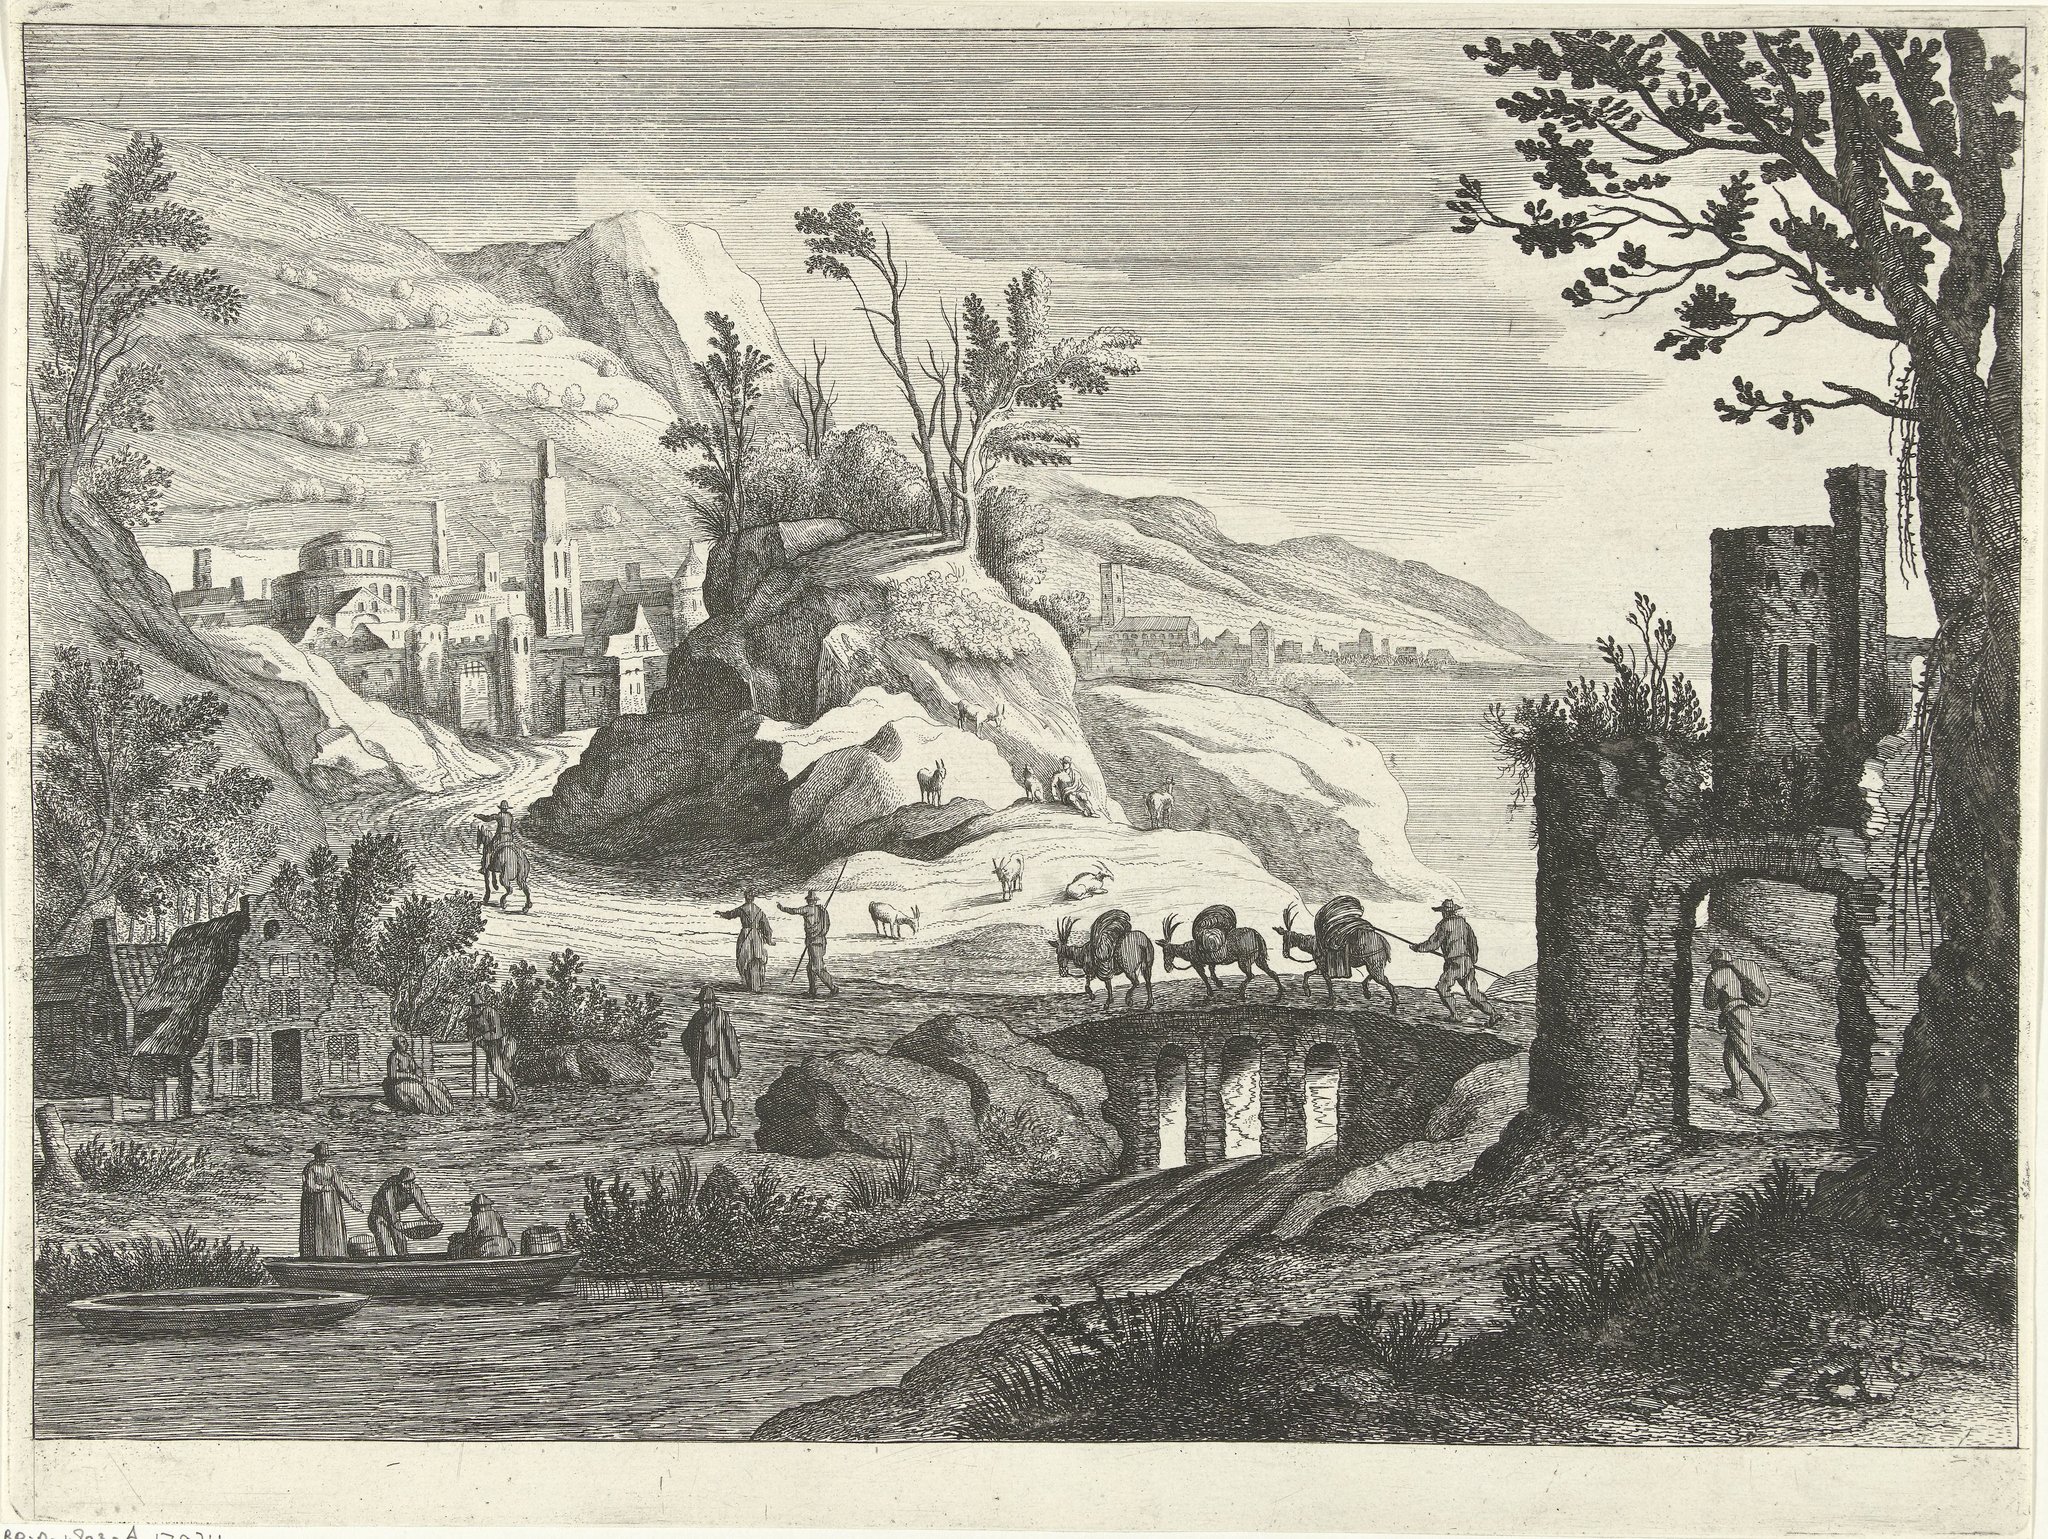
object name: print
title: Italiaans landschap met gezicht op een stad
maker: willem van de lande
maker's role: print maker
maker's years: 1610-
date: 1635-1650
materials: paper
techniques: etching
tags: ass, donkey, outskirts of city - ii - ideal city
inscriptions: collector's mark: Lugt 2228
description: Italiaans landschap met links een gezicht op een stad. Op de voorgrond worden drie bepakte ezels over een brug gedreven. Figuren lopen over een landweg in de richting van de stad. De prent maakt deel uit van een zesdelige serie prenten met Italiaanse landschappen.